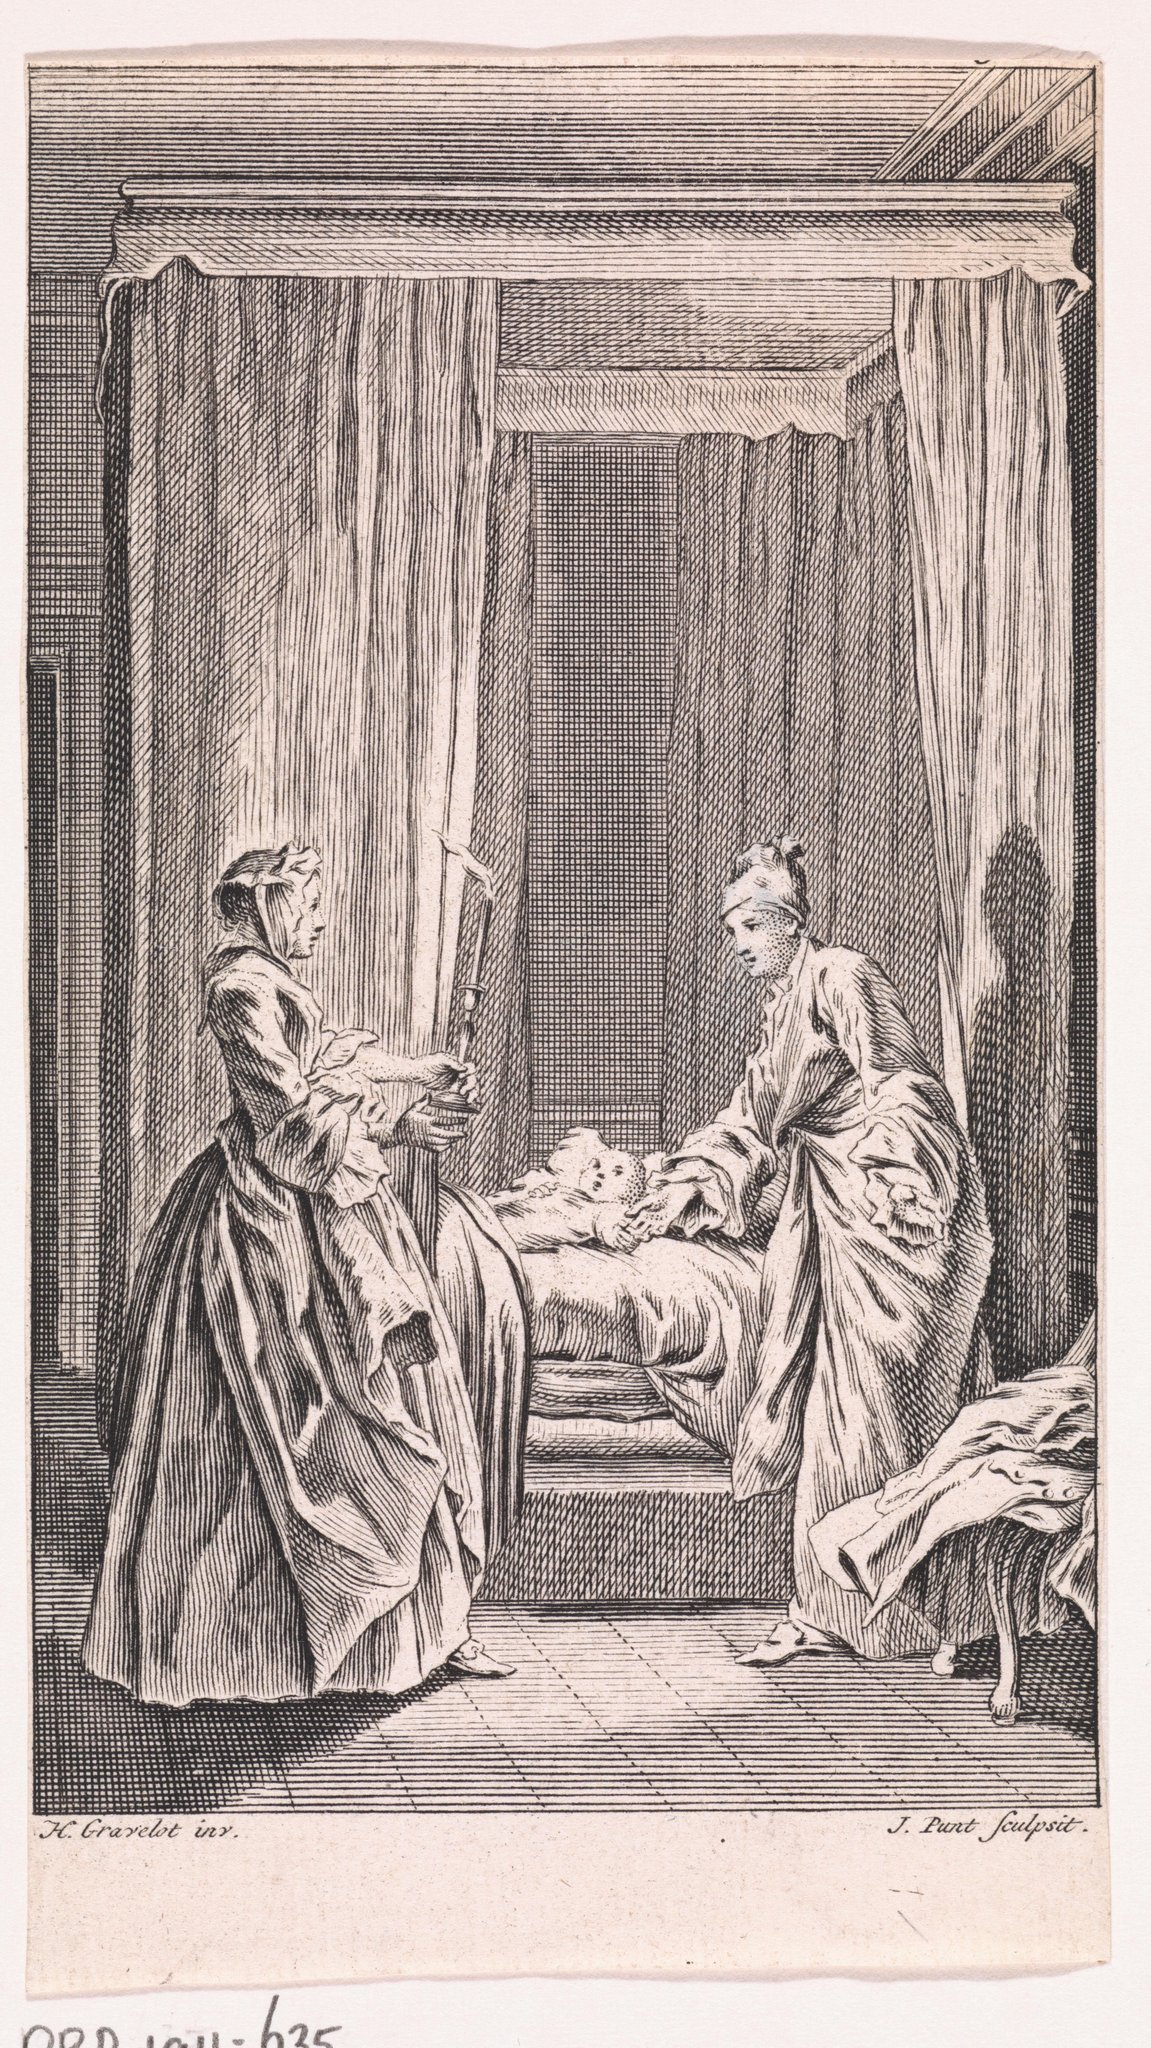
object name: book illustration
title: Debora Wilkins ontdekt een baby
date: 1749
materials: paper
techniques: engraving, etching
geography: amsterdam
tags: infant, baby, bedroom, specific works of literature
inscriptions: collector's mark: Lugt 2228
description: Prent gebruikt als illustratie in: Fielding, Henry. [Vertaald uit het Engels door] Pieter Le Clercq. Historie van den vondeling Tomas Jones, dl. 1, p. 12. Amsterdam: Gerrit de Groot, 1749.